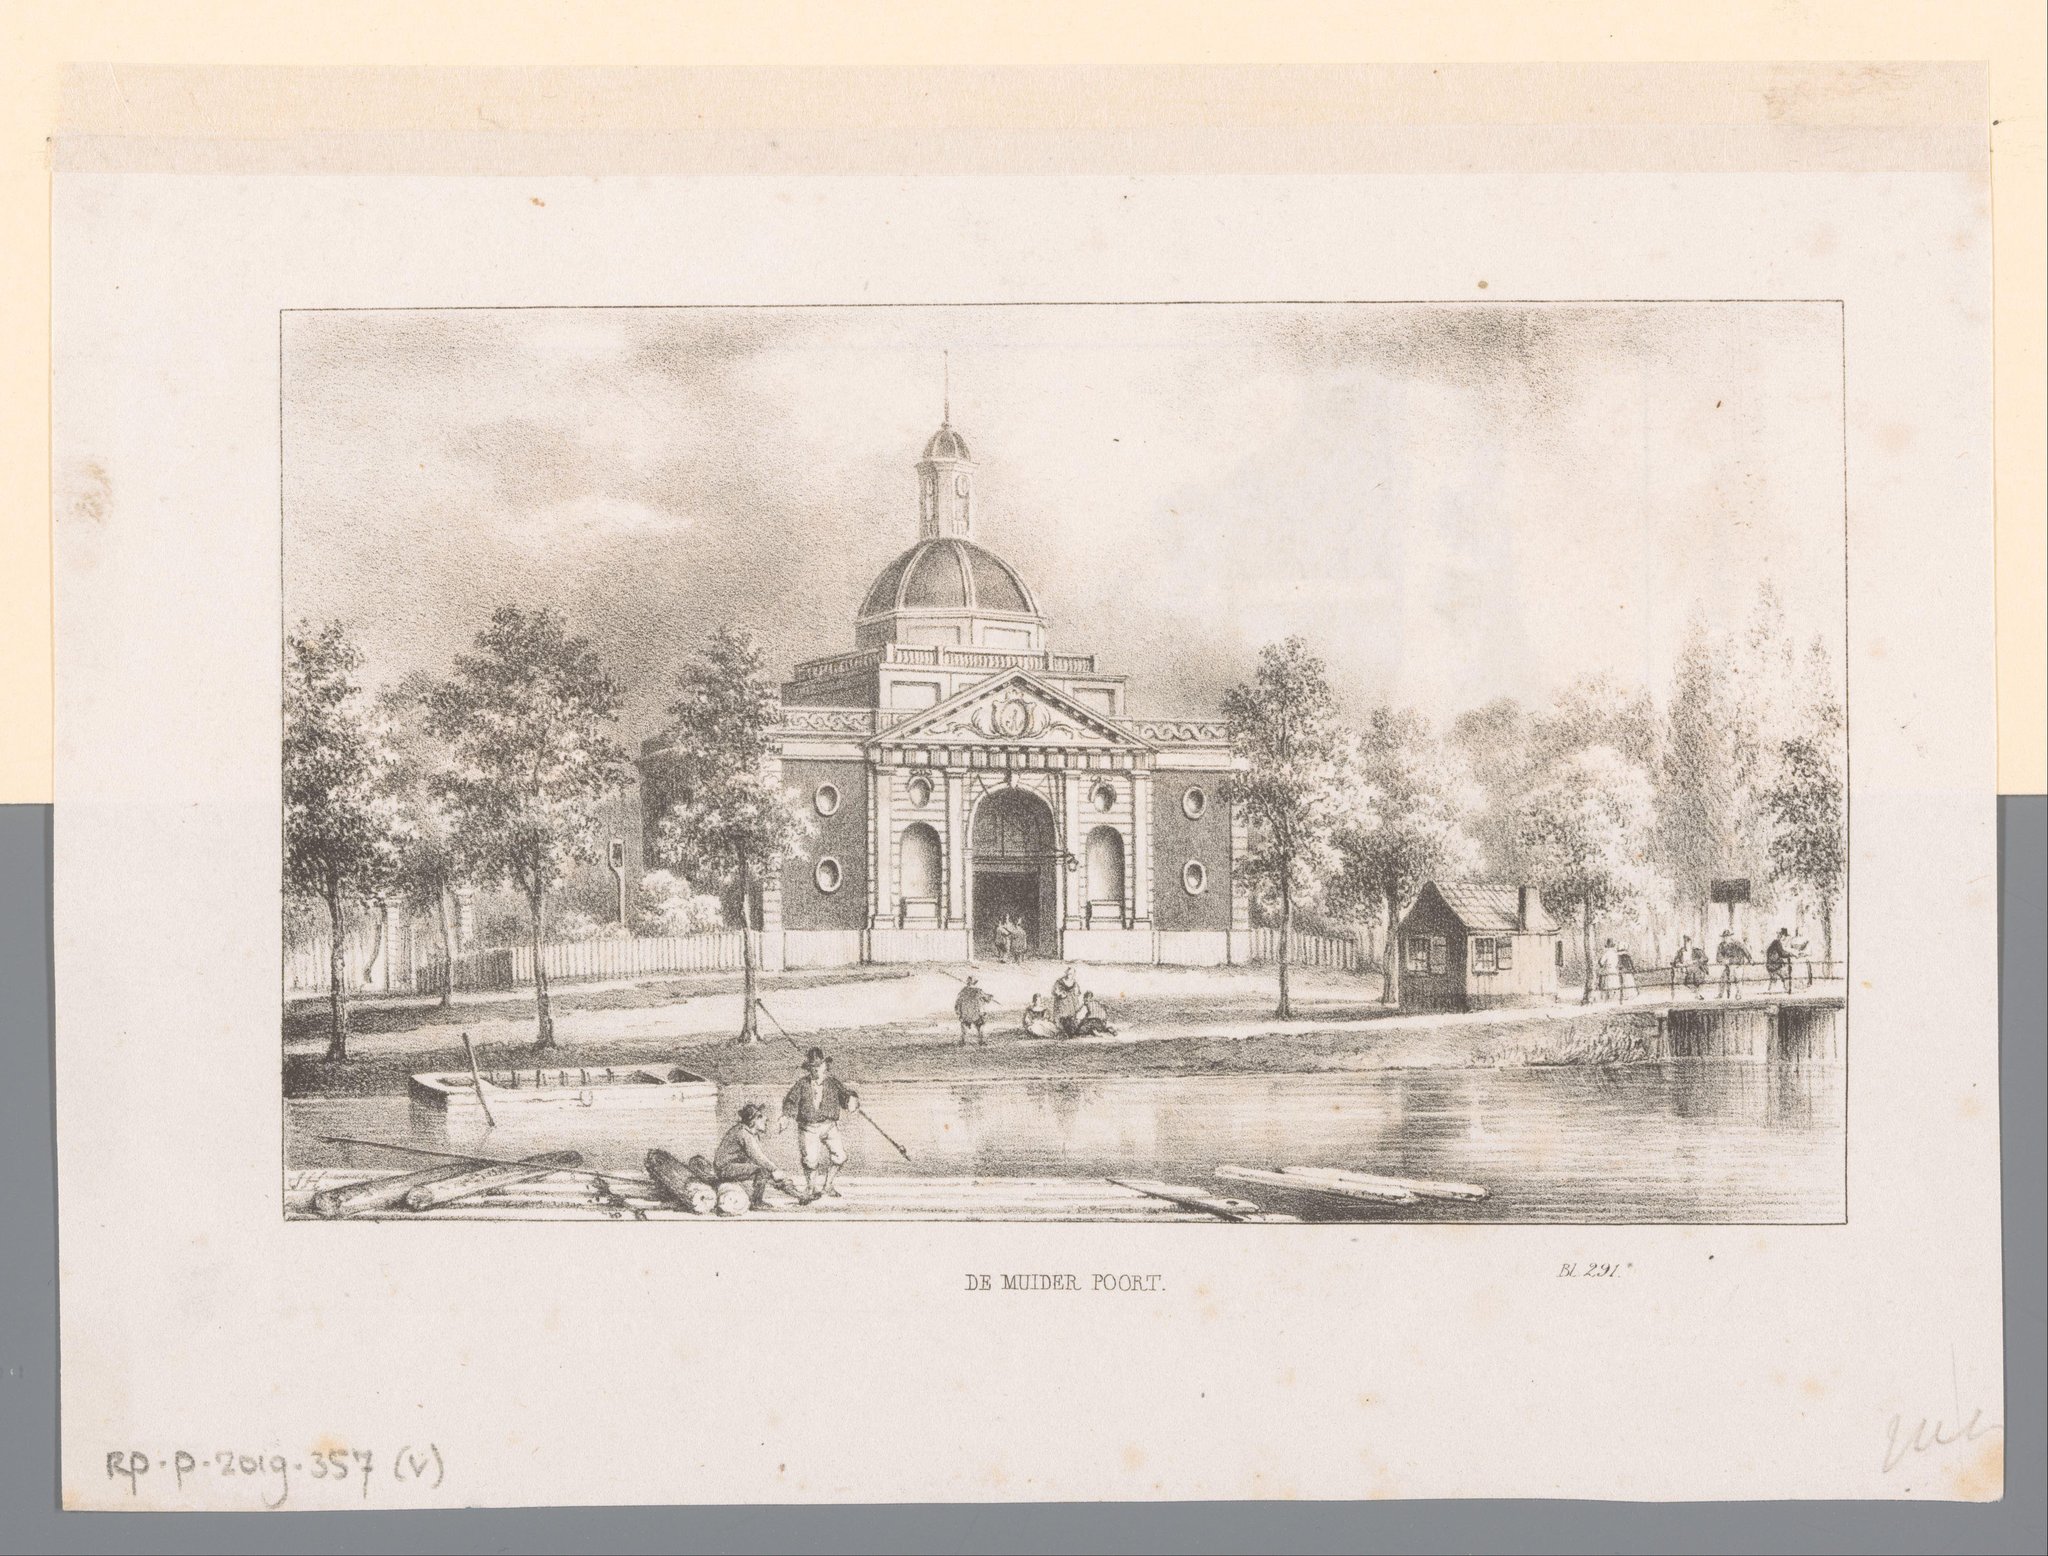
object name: print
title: Gezicht op de Muiderpoort in Amsterdam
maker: Anonymous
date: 1830-1900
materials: paper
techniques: lithograph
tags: city-gate